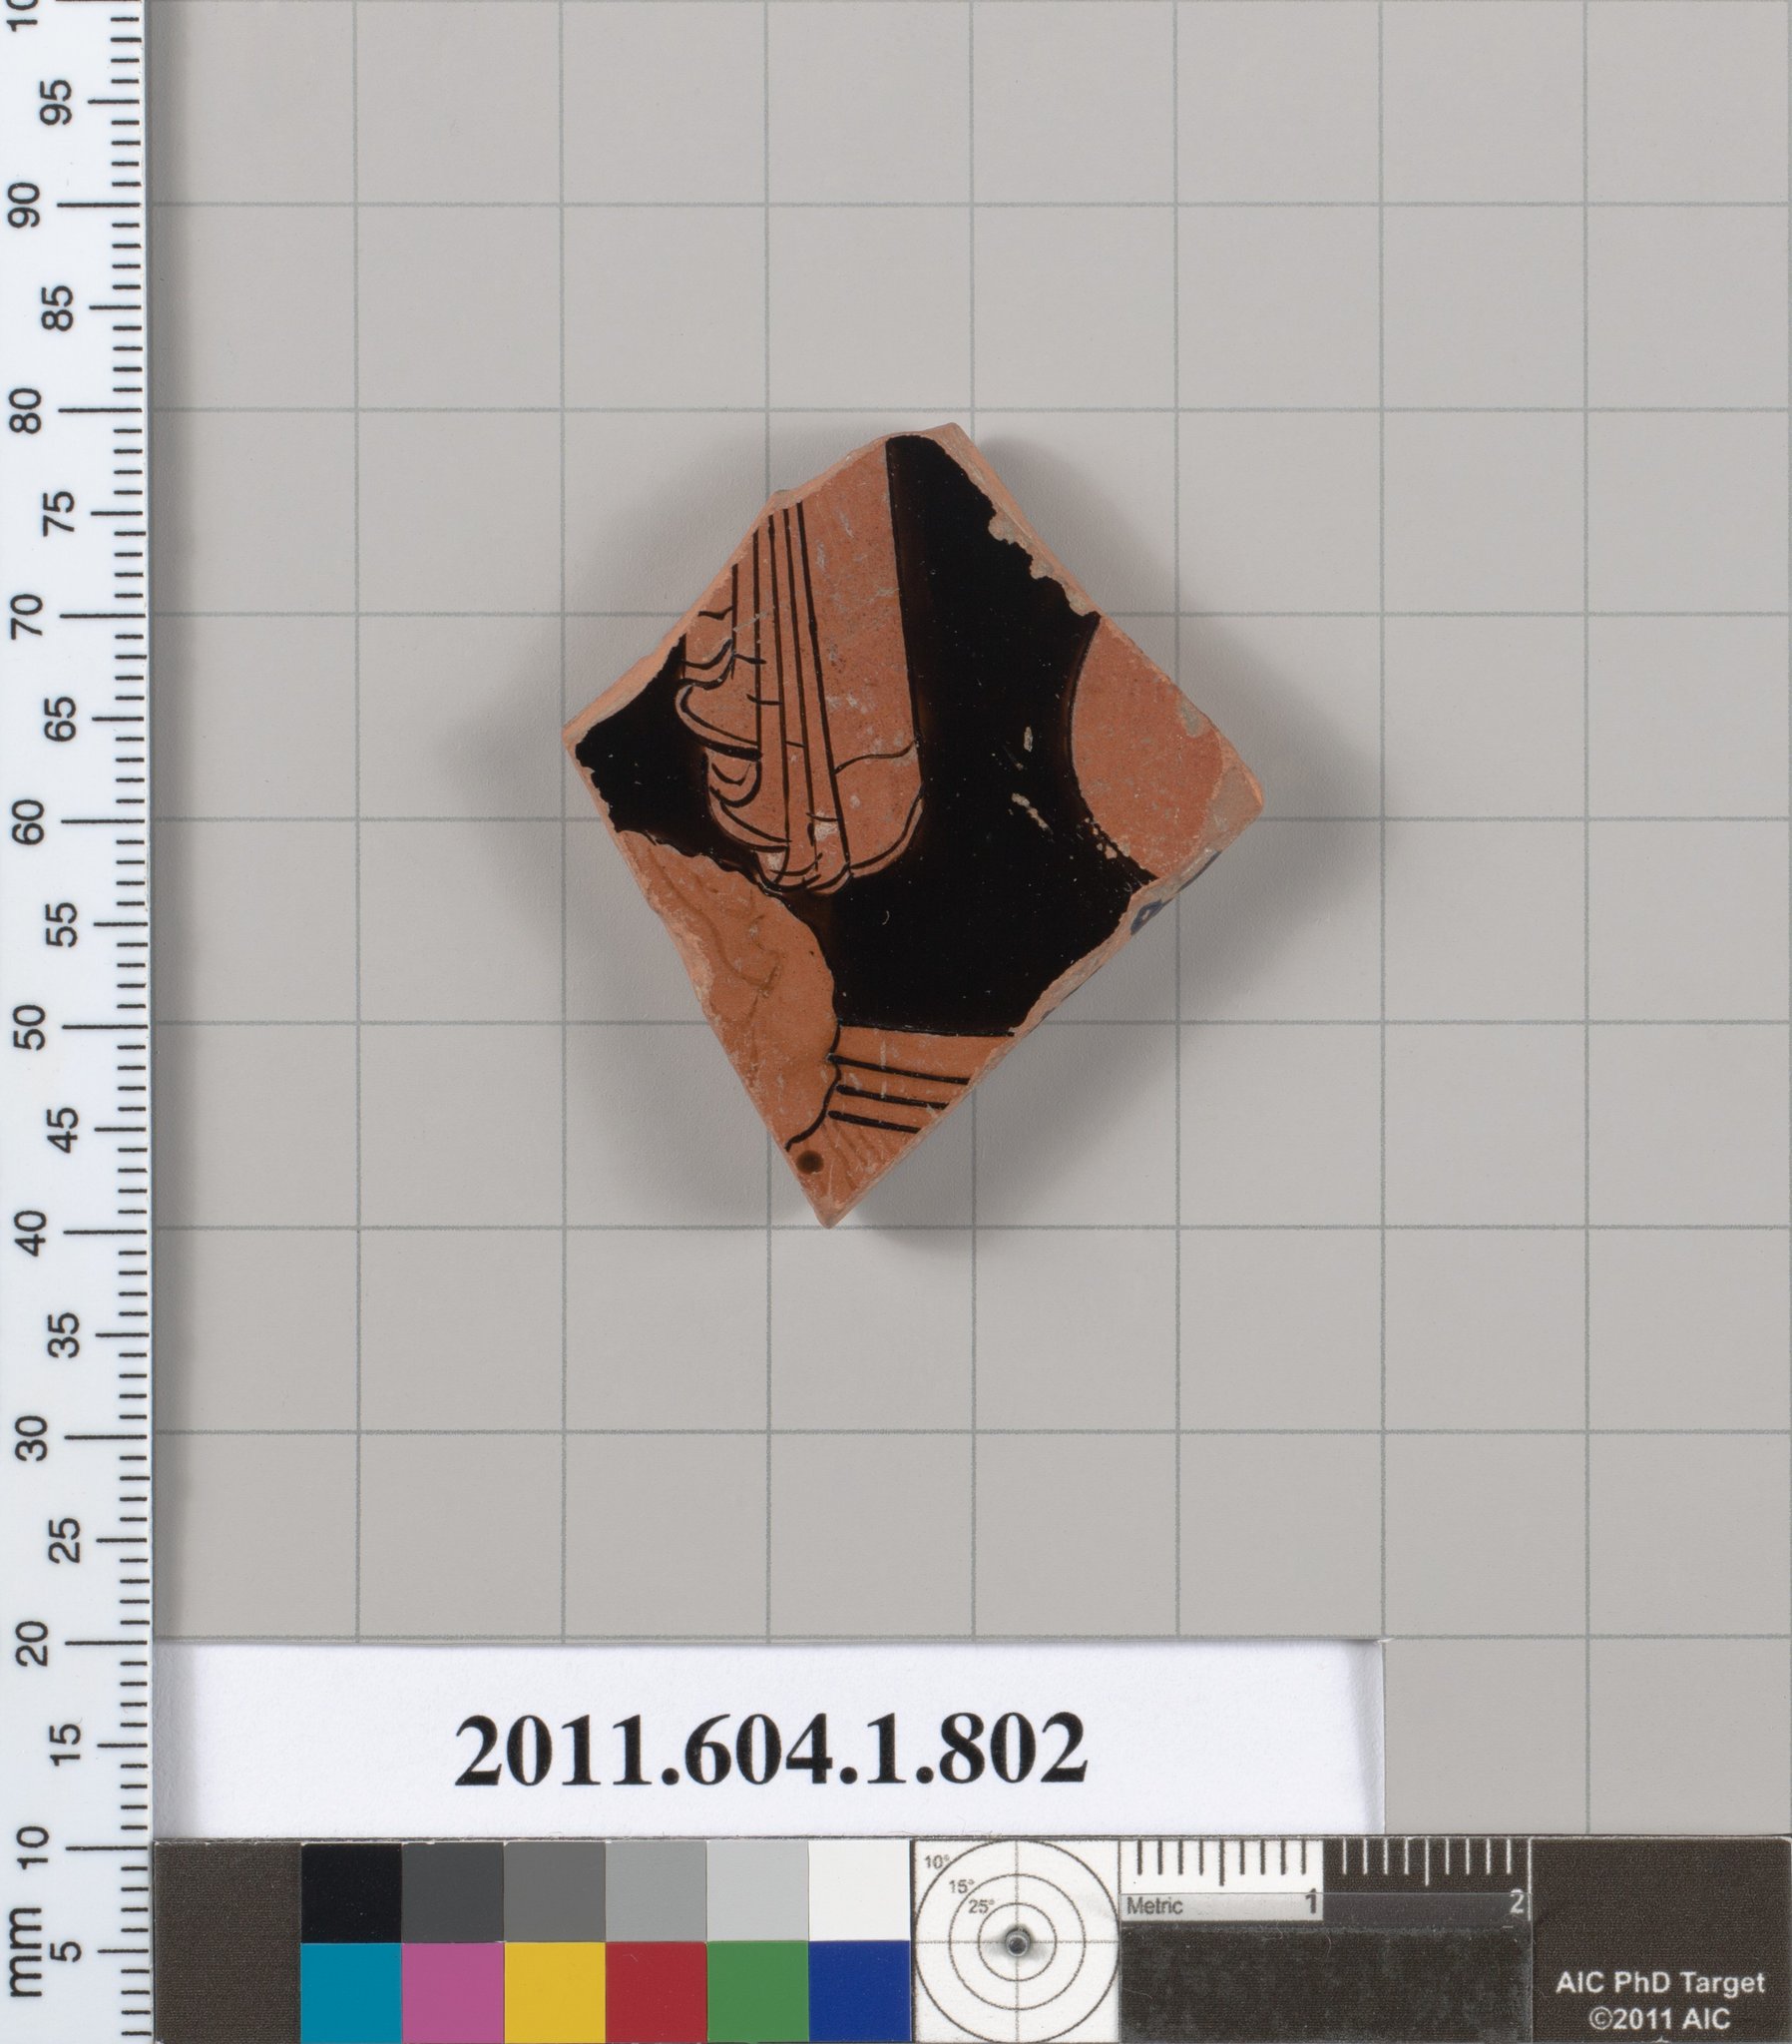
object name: kylix fragment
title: Terracotta fragment of a kylix (drinking cup)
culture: greek, attic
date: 490-480 BCE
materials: terracotta